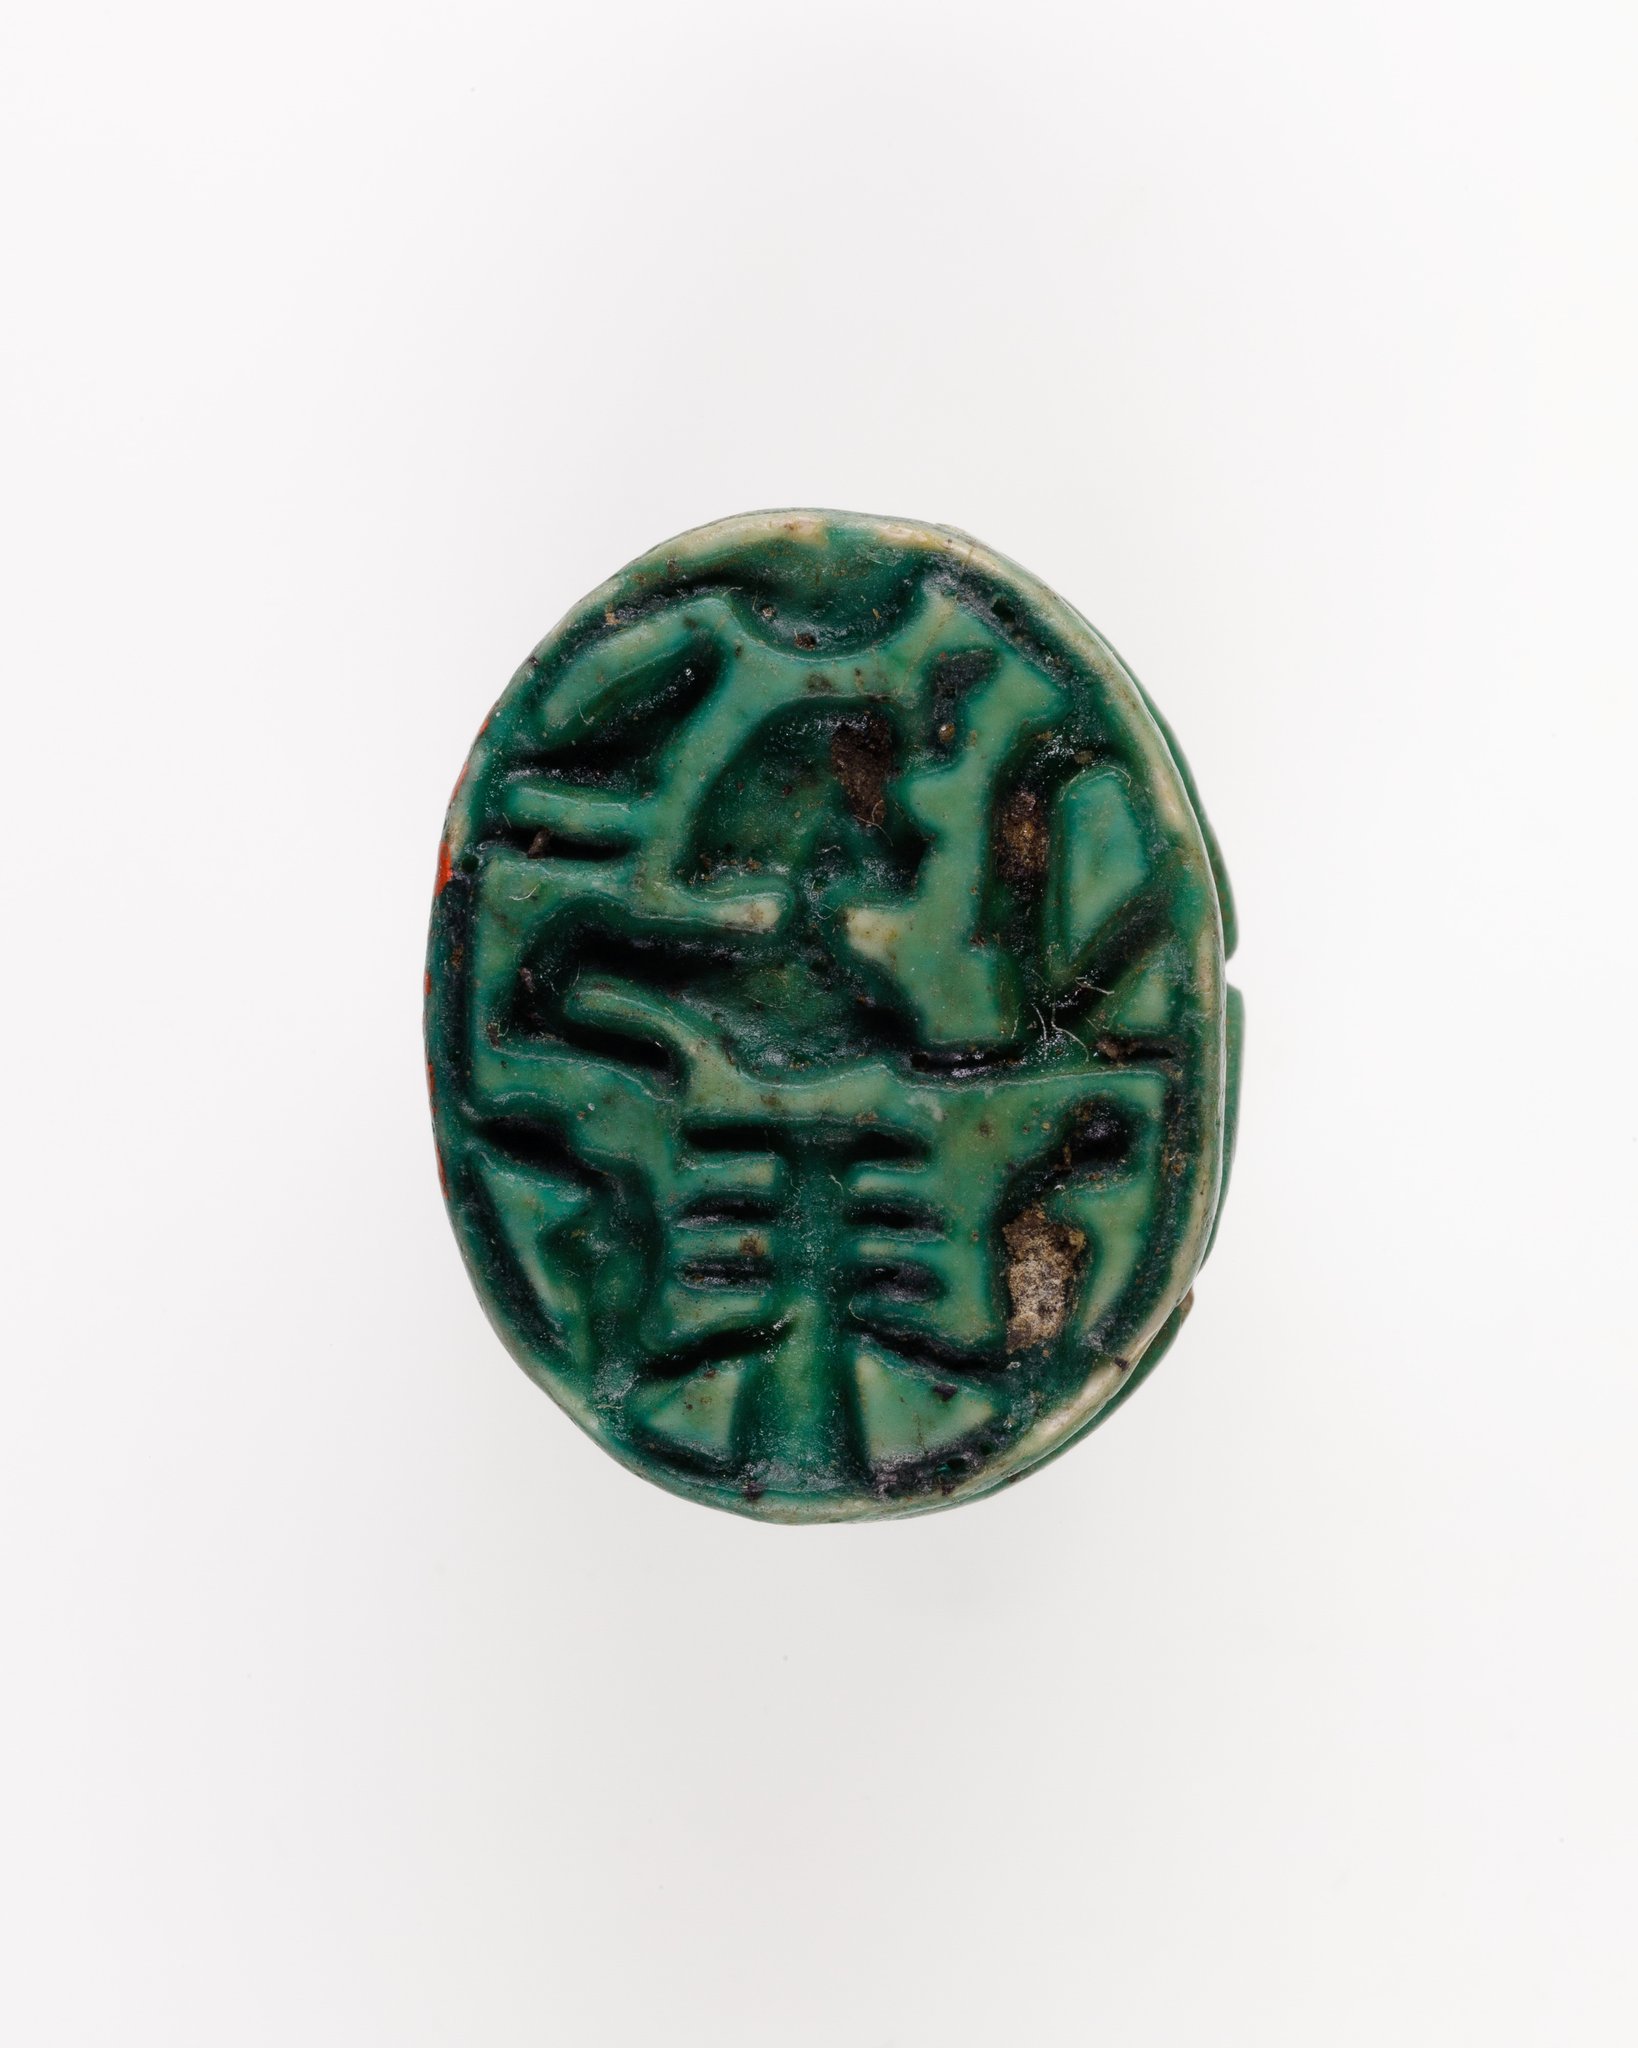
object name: scarab, sphinx, maat, djed, uraus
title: Human-face Scarab with Sphinx and Hieroglyphs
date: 1295-1070 BCE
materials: stone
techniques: glazing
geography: egypt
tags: scarabs